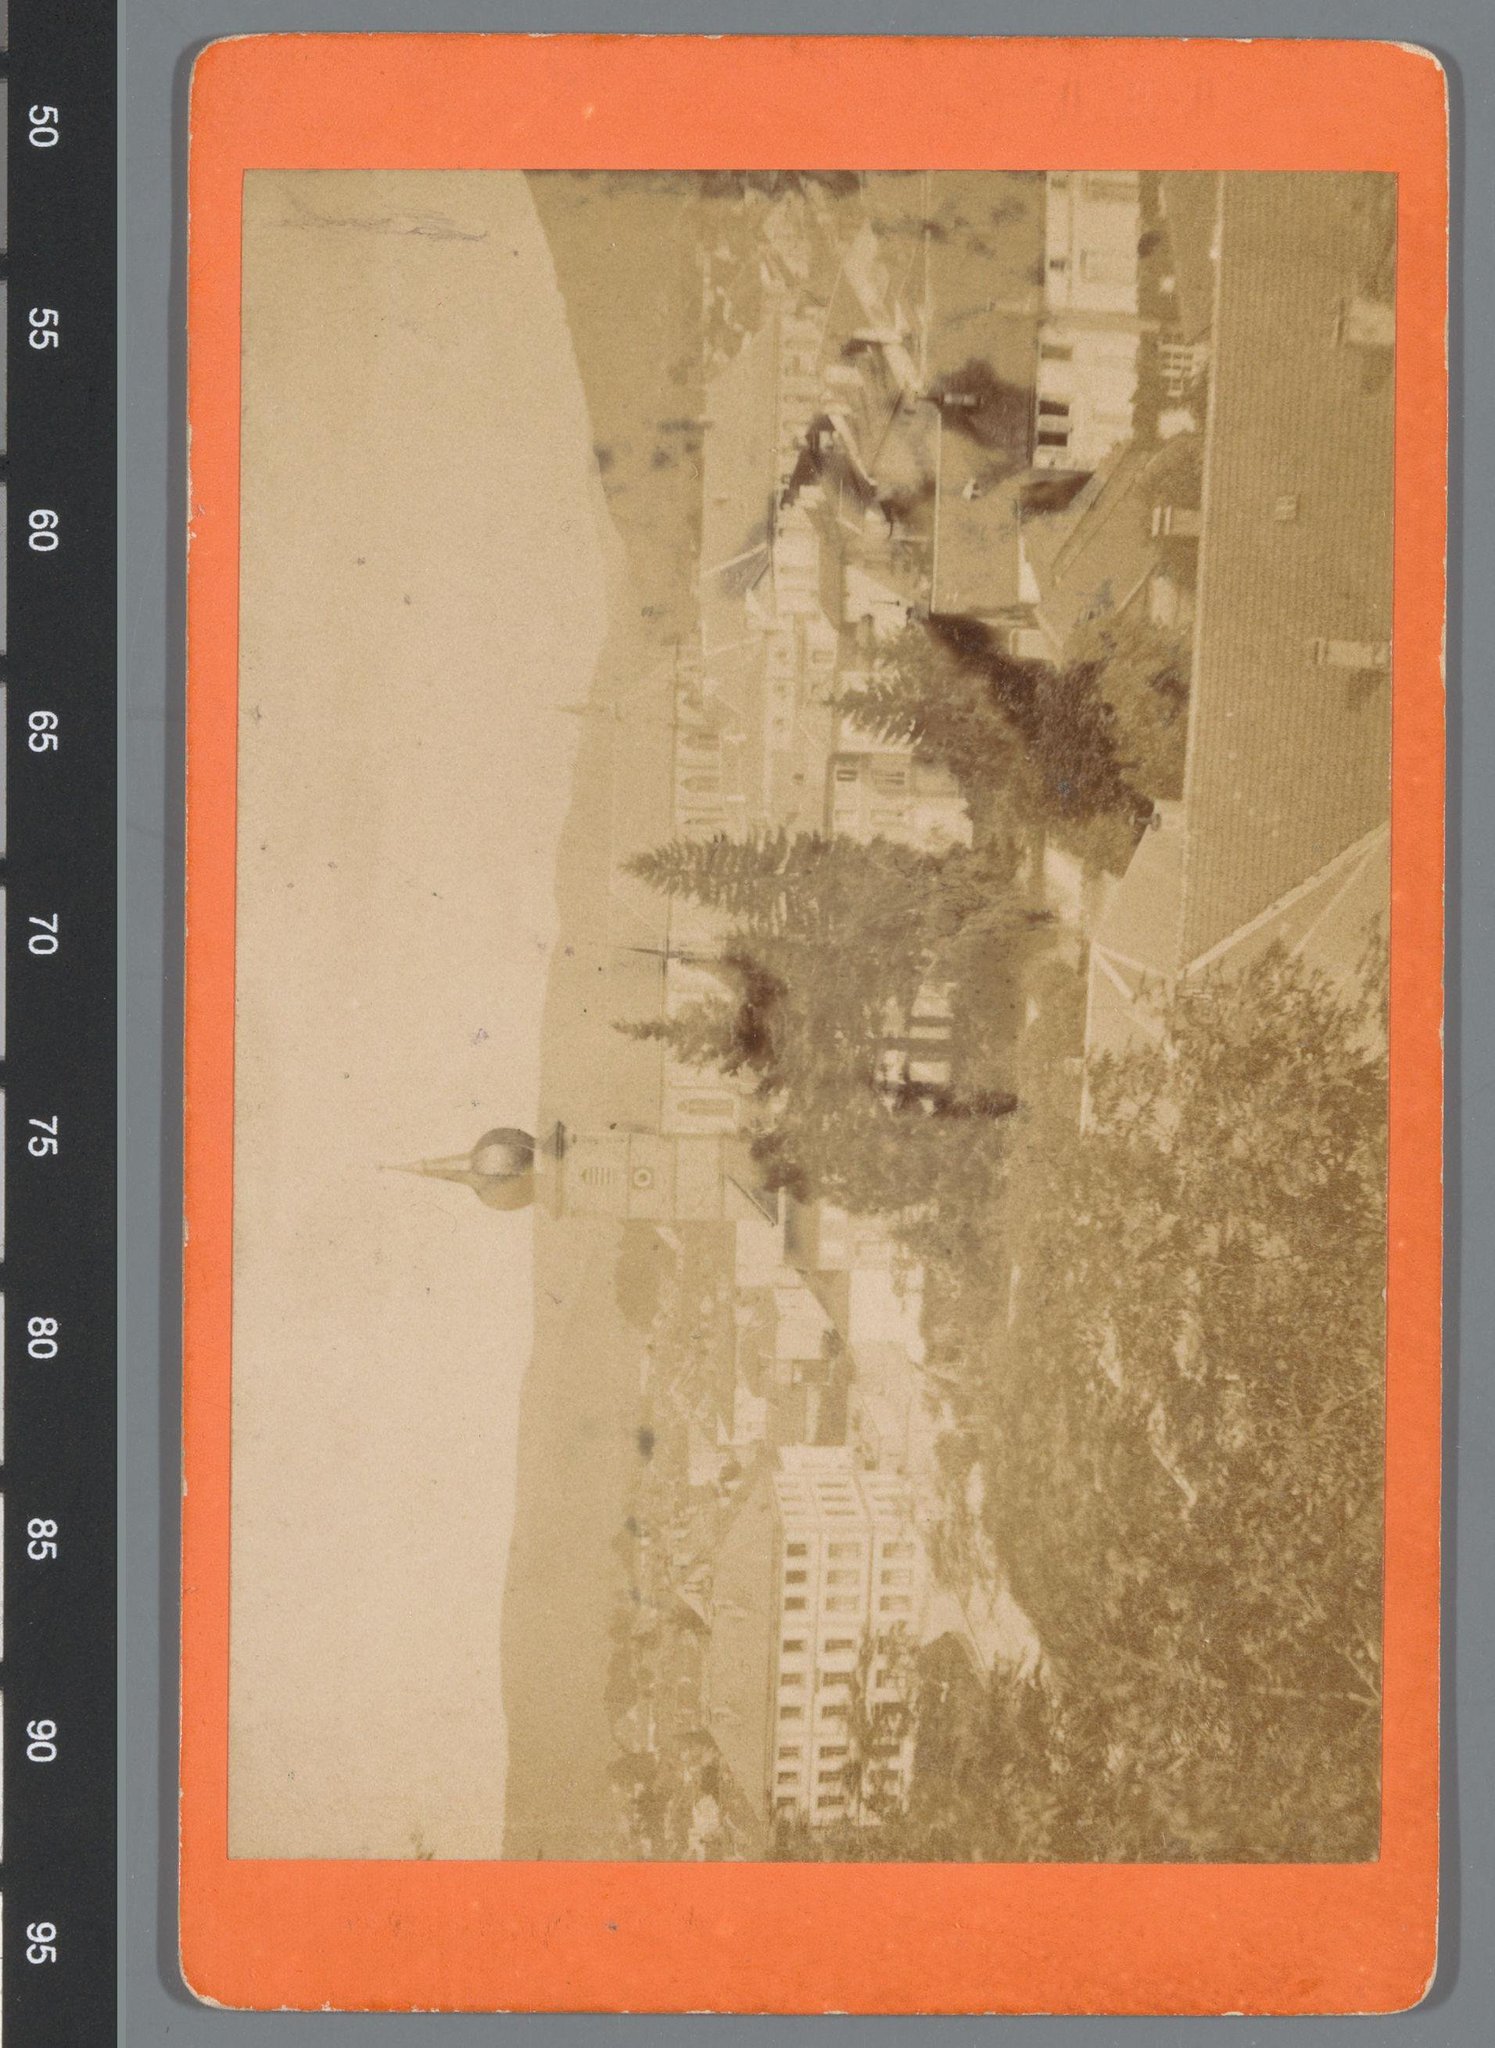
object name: photograph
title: Sites des Vosges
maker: Anonymous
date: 1881-1900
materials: cardboard, paper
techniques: albumen print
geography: remiremont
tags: city-view in general; 'veduta'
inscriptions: number: ‘31’, inscription: ‘Ad. Braun & Cie./ photographes/ a/ Dornach (Alsace)/ &/ Paris/ 3, Boulevard des Capucines, 3/ 43, Avenue de l'Opéra, 43.’